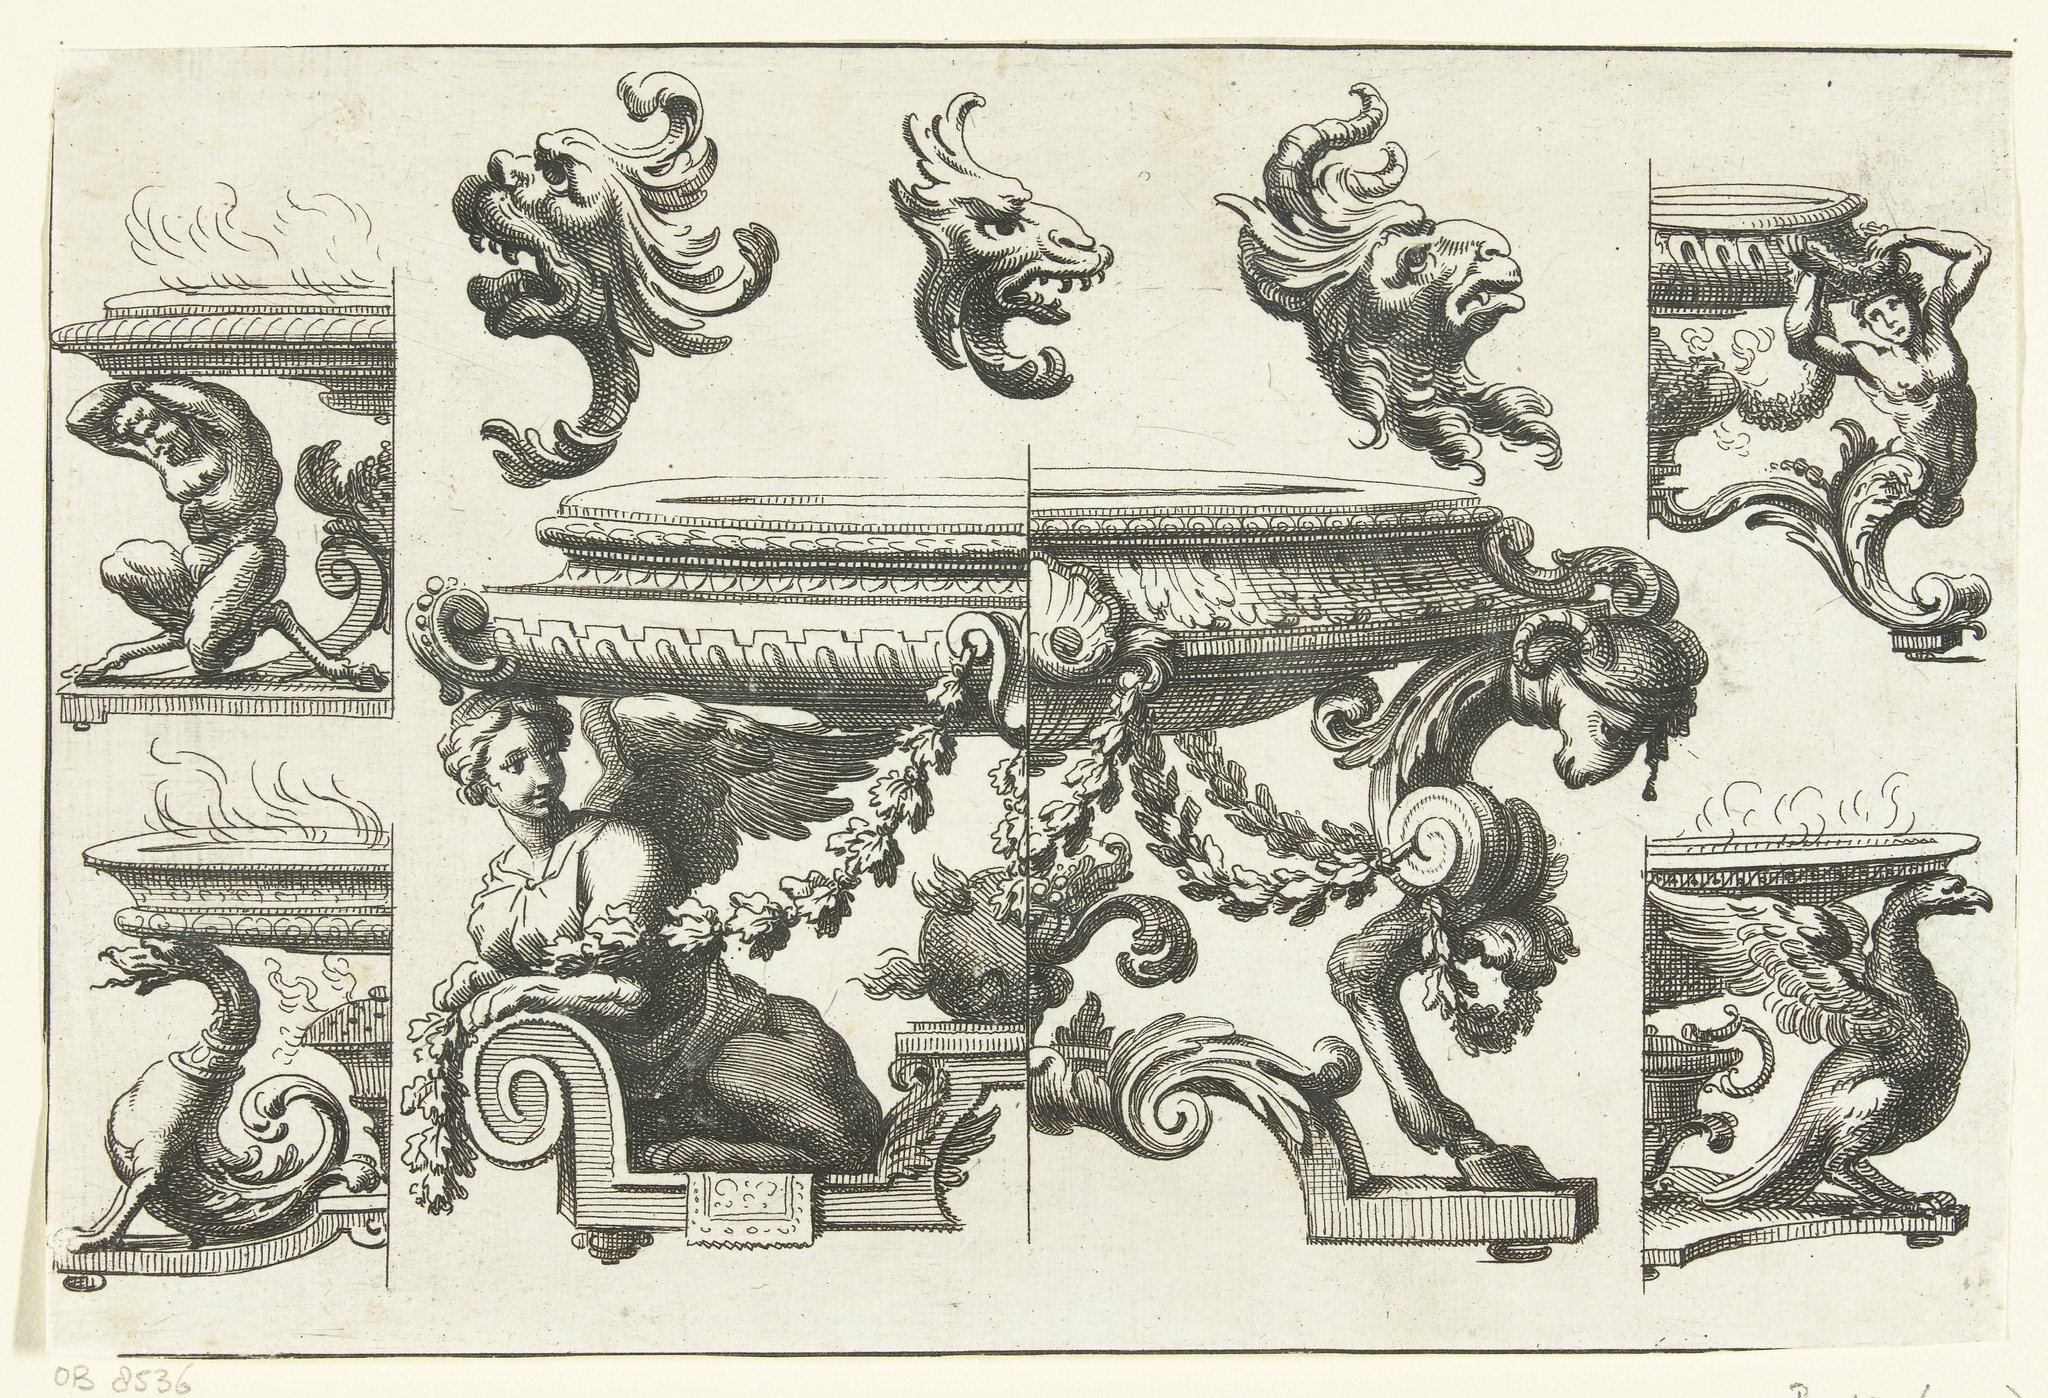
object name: print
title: Stoof met variant voor rechterhelft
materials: paper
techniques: engraving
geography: paris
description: De linkerkant van de stoof wordt gedragen door een sfinx, de rechterkant door een console met de kop van een ram en de poot van een geit. Links en rechts staan twee halve stoven en middenboven drie dierenmaskers. Blad 6 uit serie van 6 bladen, eerste editie.